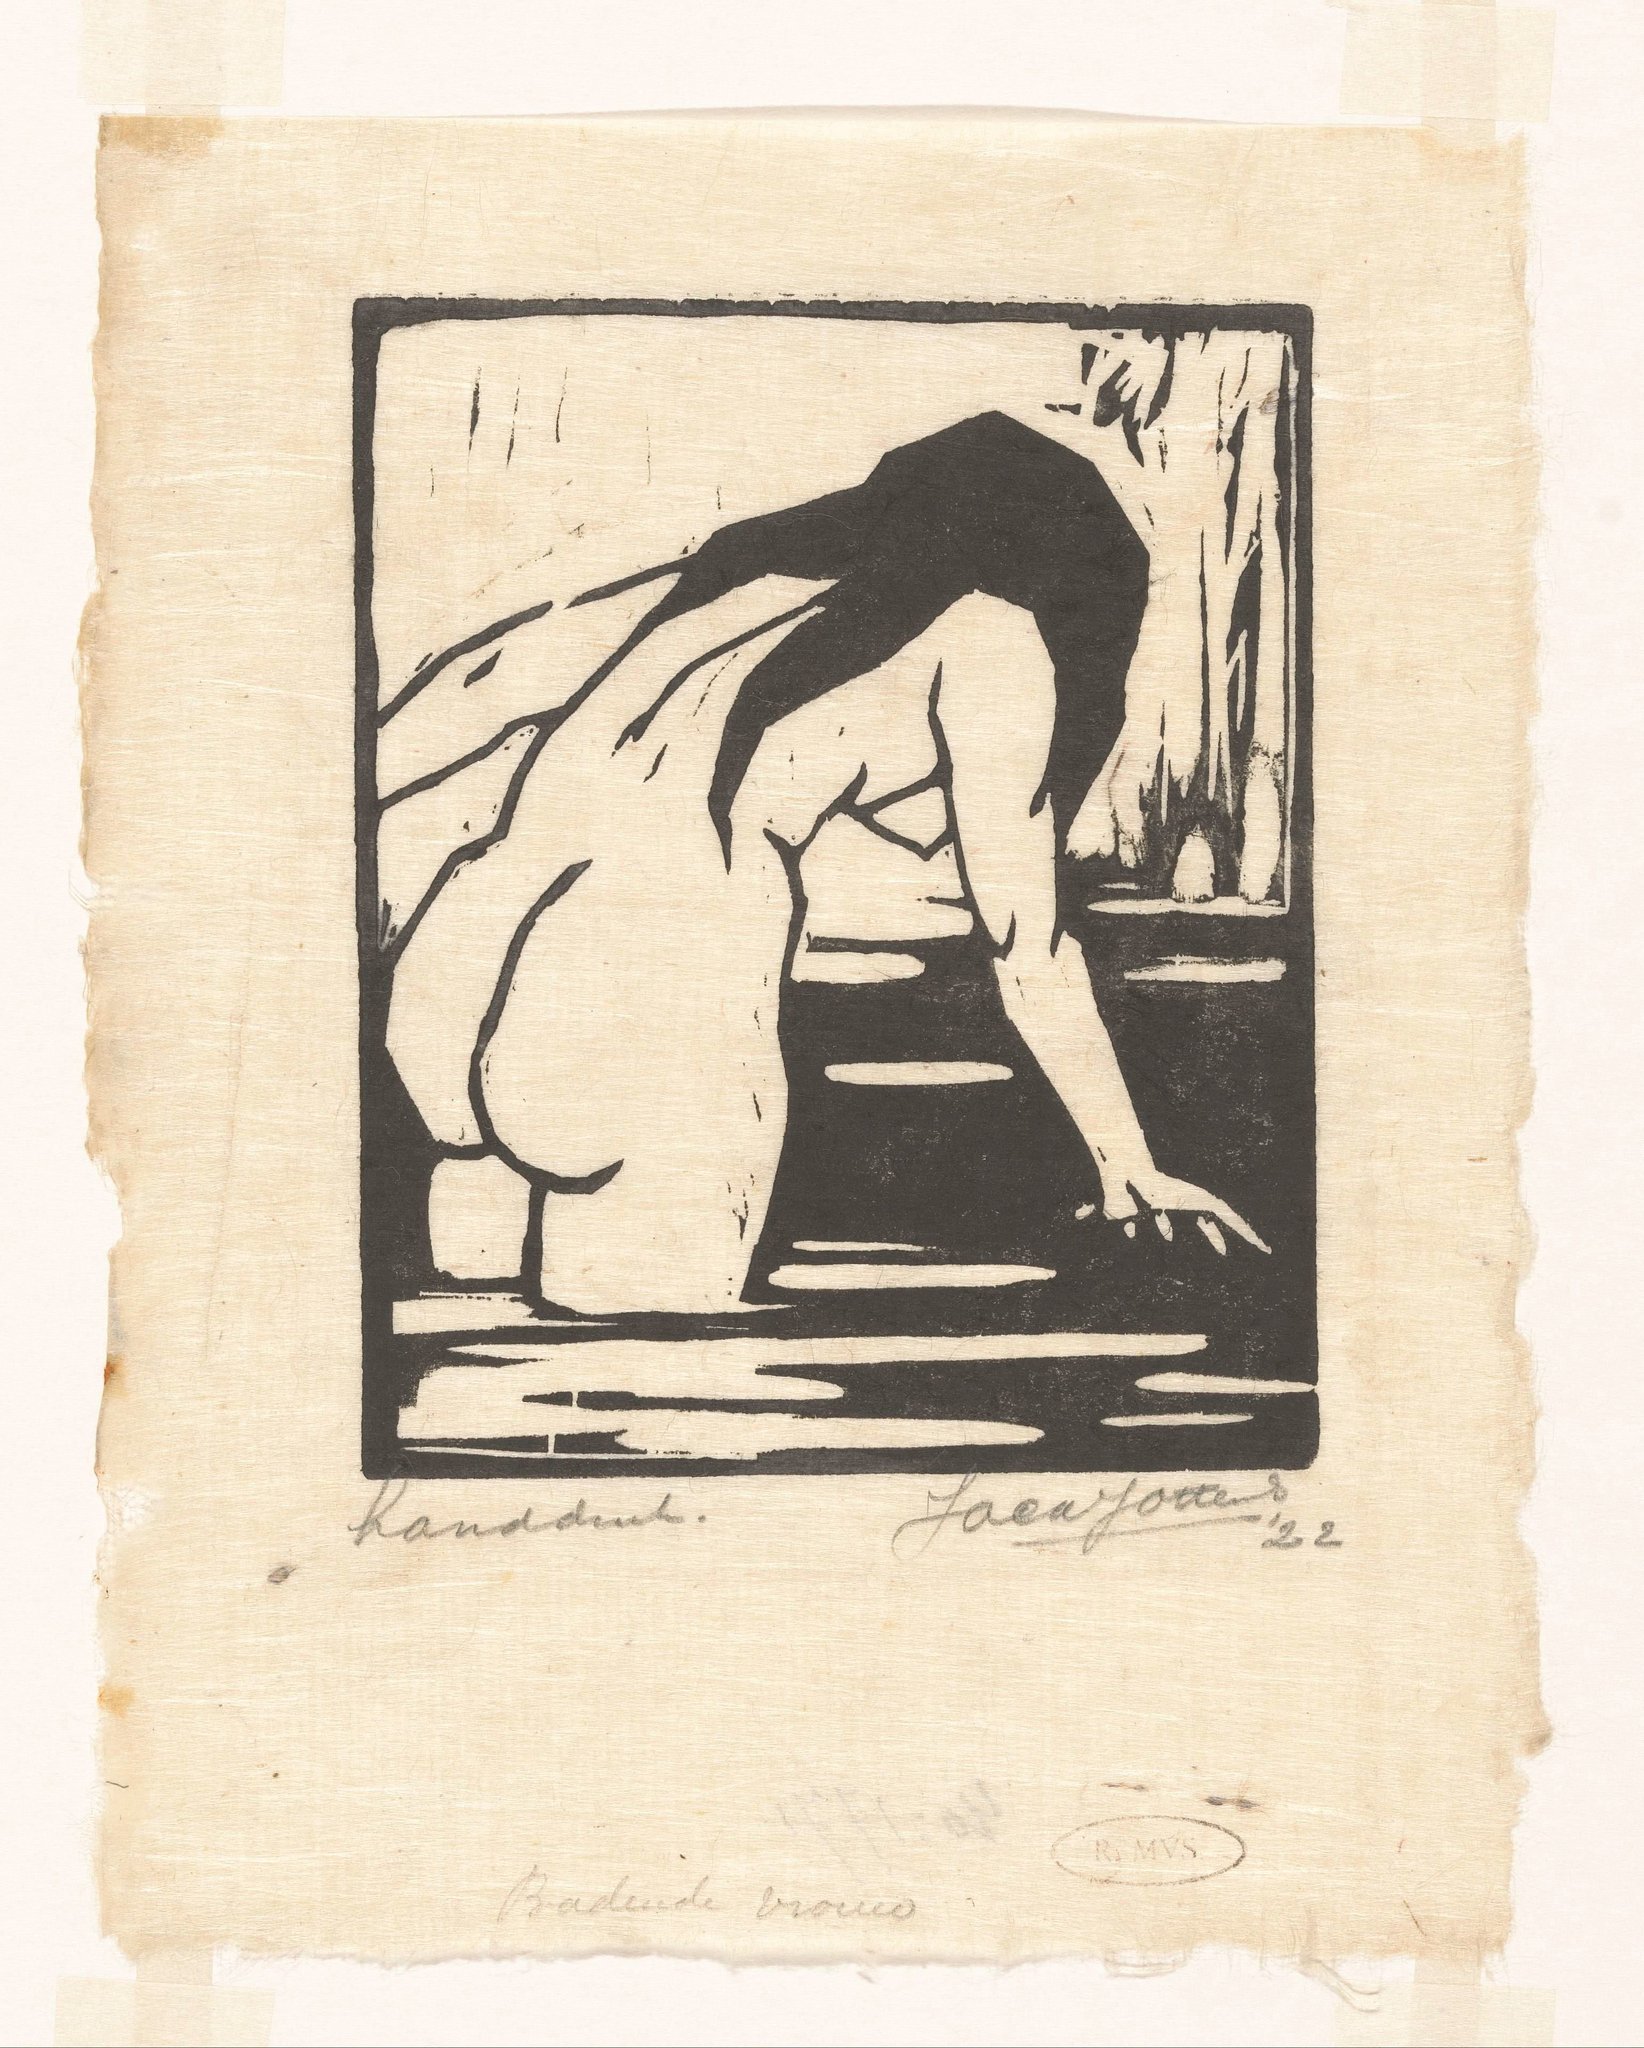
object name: print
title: Badende vrouw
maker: jacques jeichienus ottens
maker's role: print maker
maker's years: 1895-1930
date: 1922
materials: paper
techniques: woodcut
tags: woman (showing herself) undressed, quasi-nude, taking a bath - aa - in the open air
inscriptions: collector's mark: Lugt 2760, collector's mark: Lugt 2228